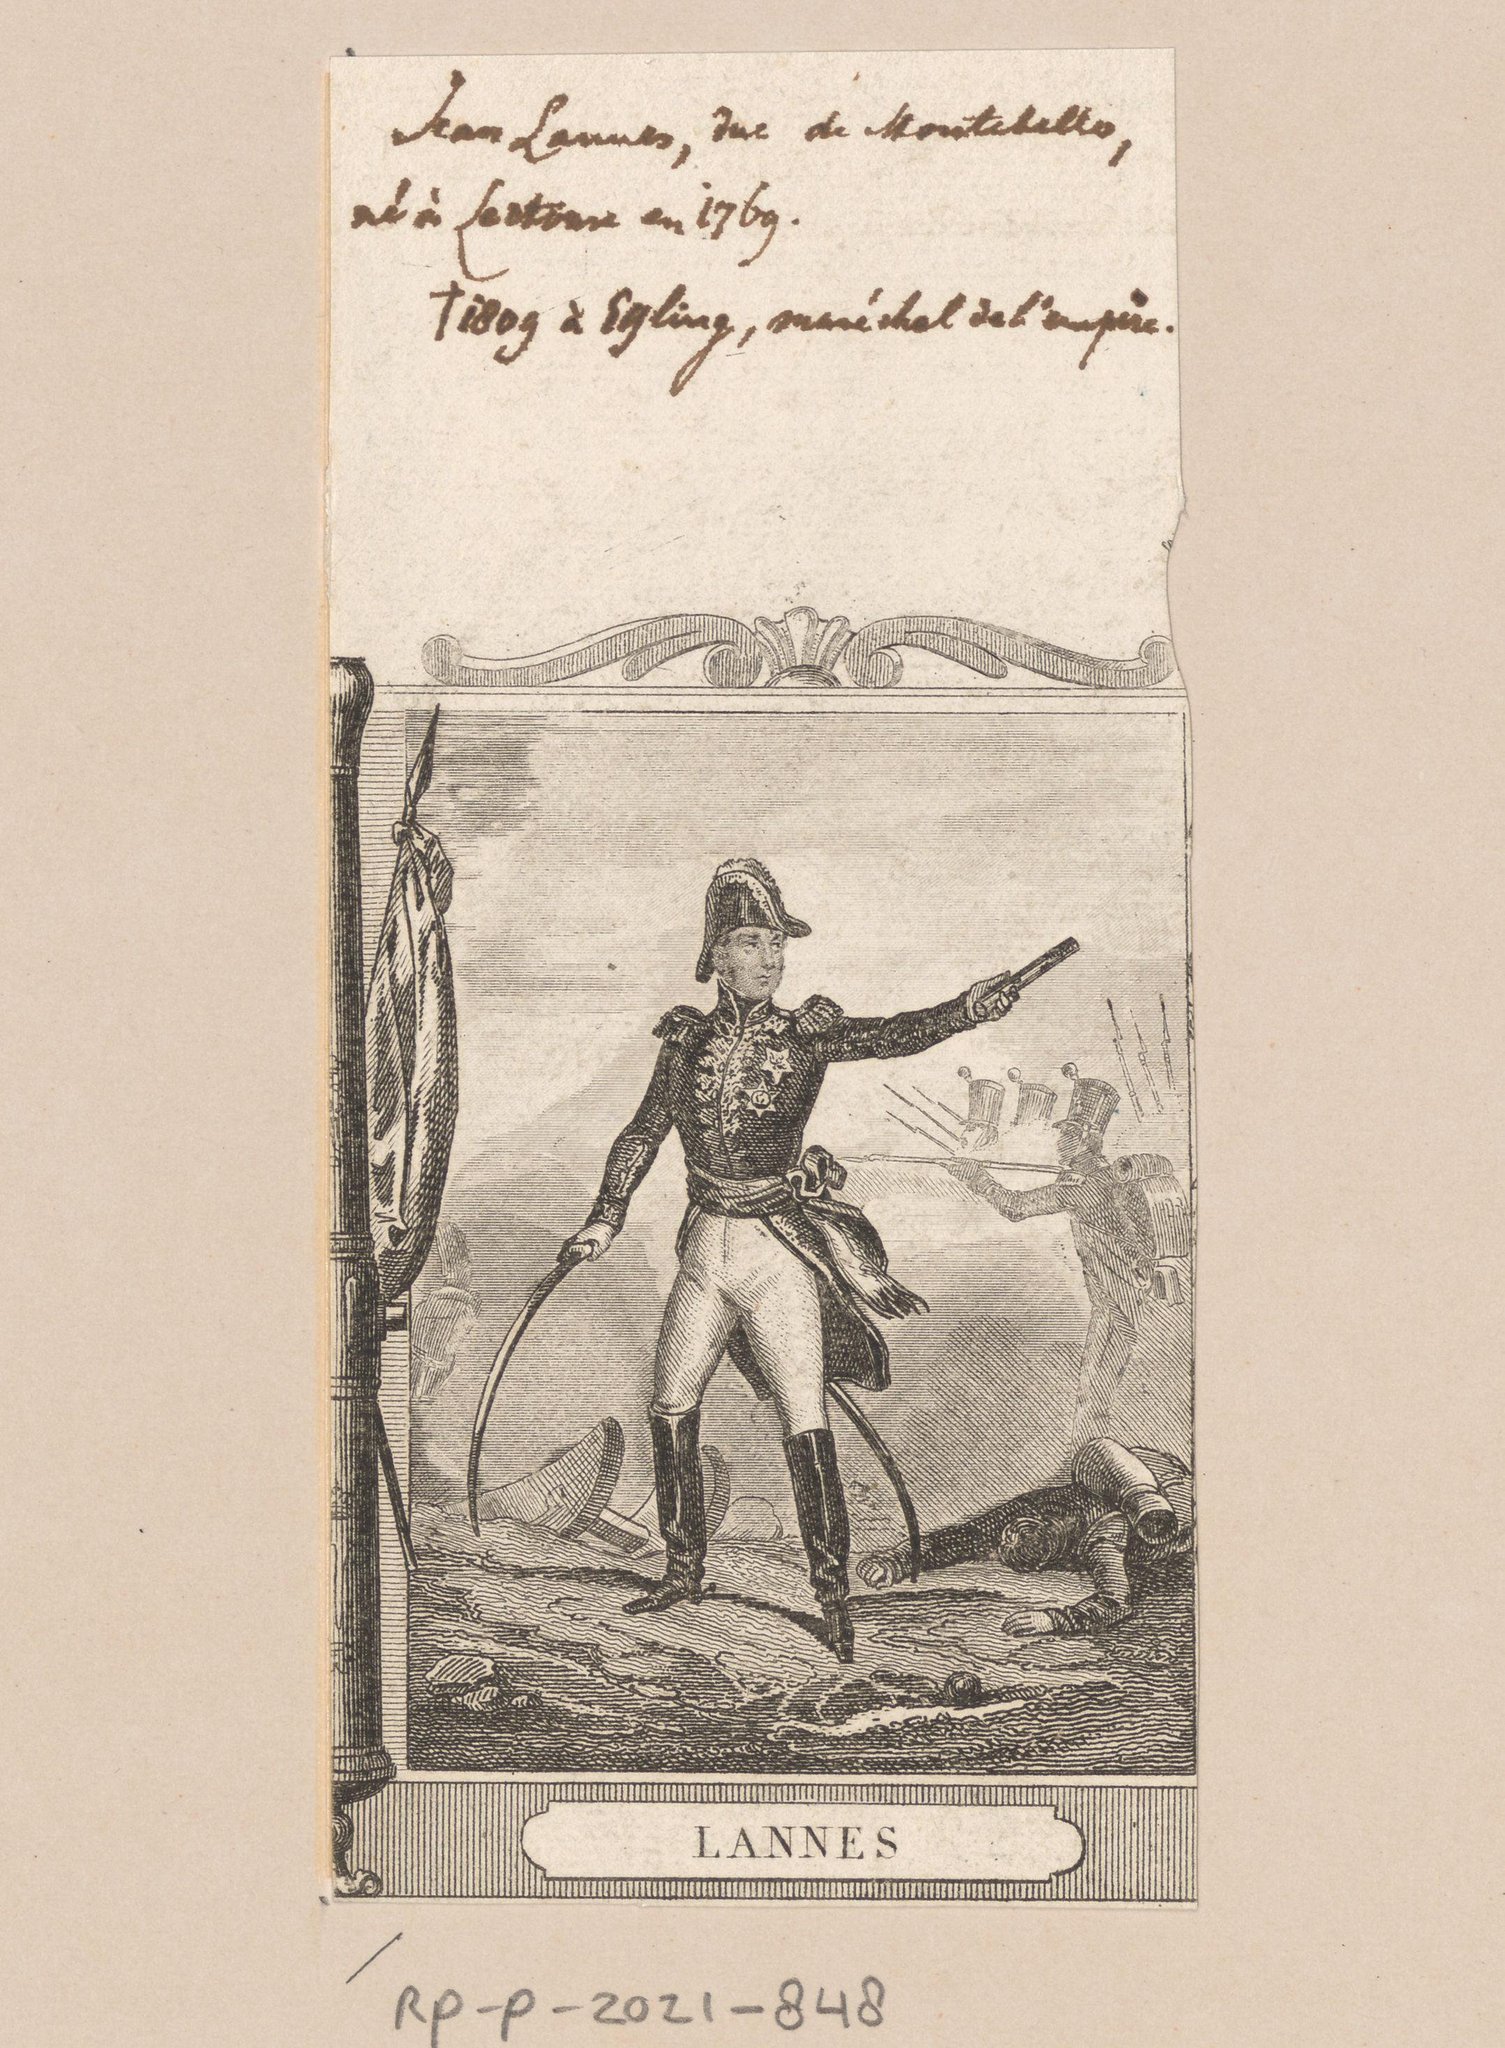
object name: print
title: Portret van Jean Lannes, hertog van Montebello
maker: Anonymous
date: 1800-1850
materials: paper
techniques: etching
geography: france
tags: commander-in-chief, general, marshal, historical persons, battle, (military) uniforms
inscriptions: inscription: ‘Jean Lannes, duc de Montebello,/ né à Lectoure en 1769./ +1809 à Egling, maréchal del' empire’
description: Portret ten voeten uit tijdens een veldslag.